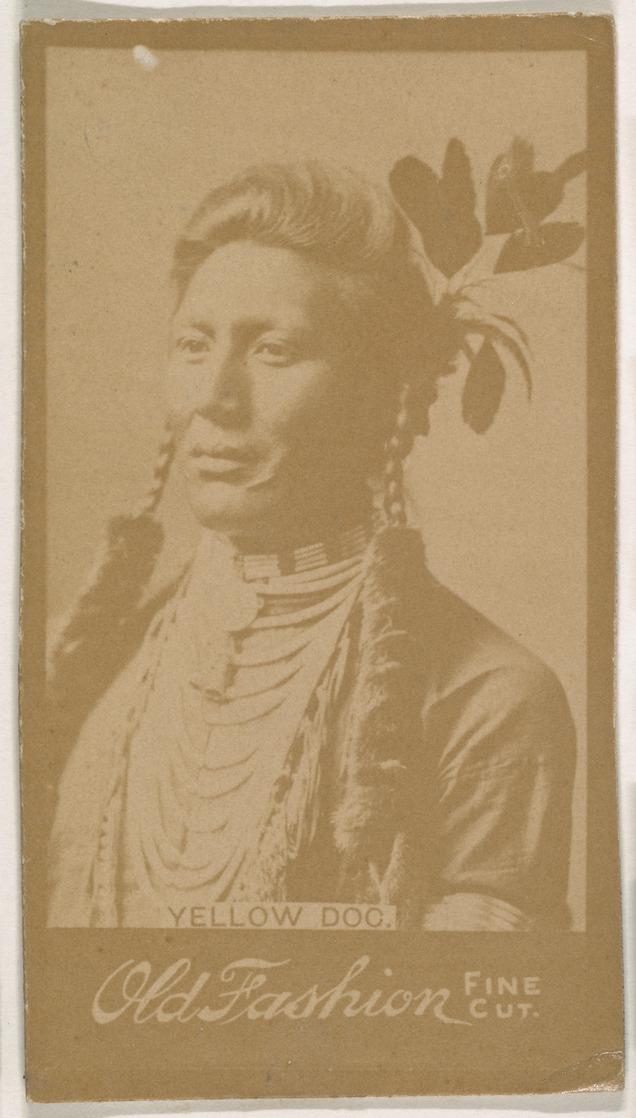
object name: photograph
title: Yellow Dog, from the Indian Chiefs series (N681) promoting Old Fashion Fine Cut Tobacco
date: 1888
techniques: albumen silver print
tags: men,portraits